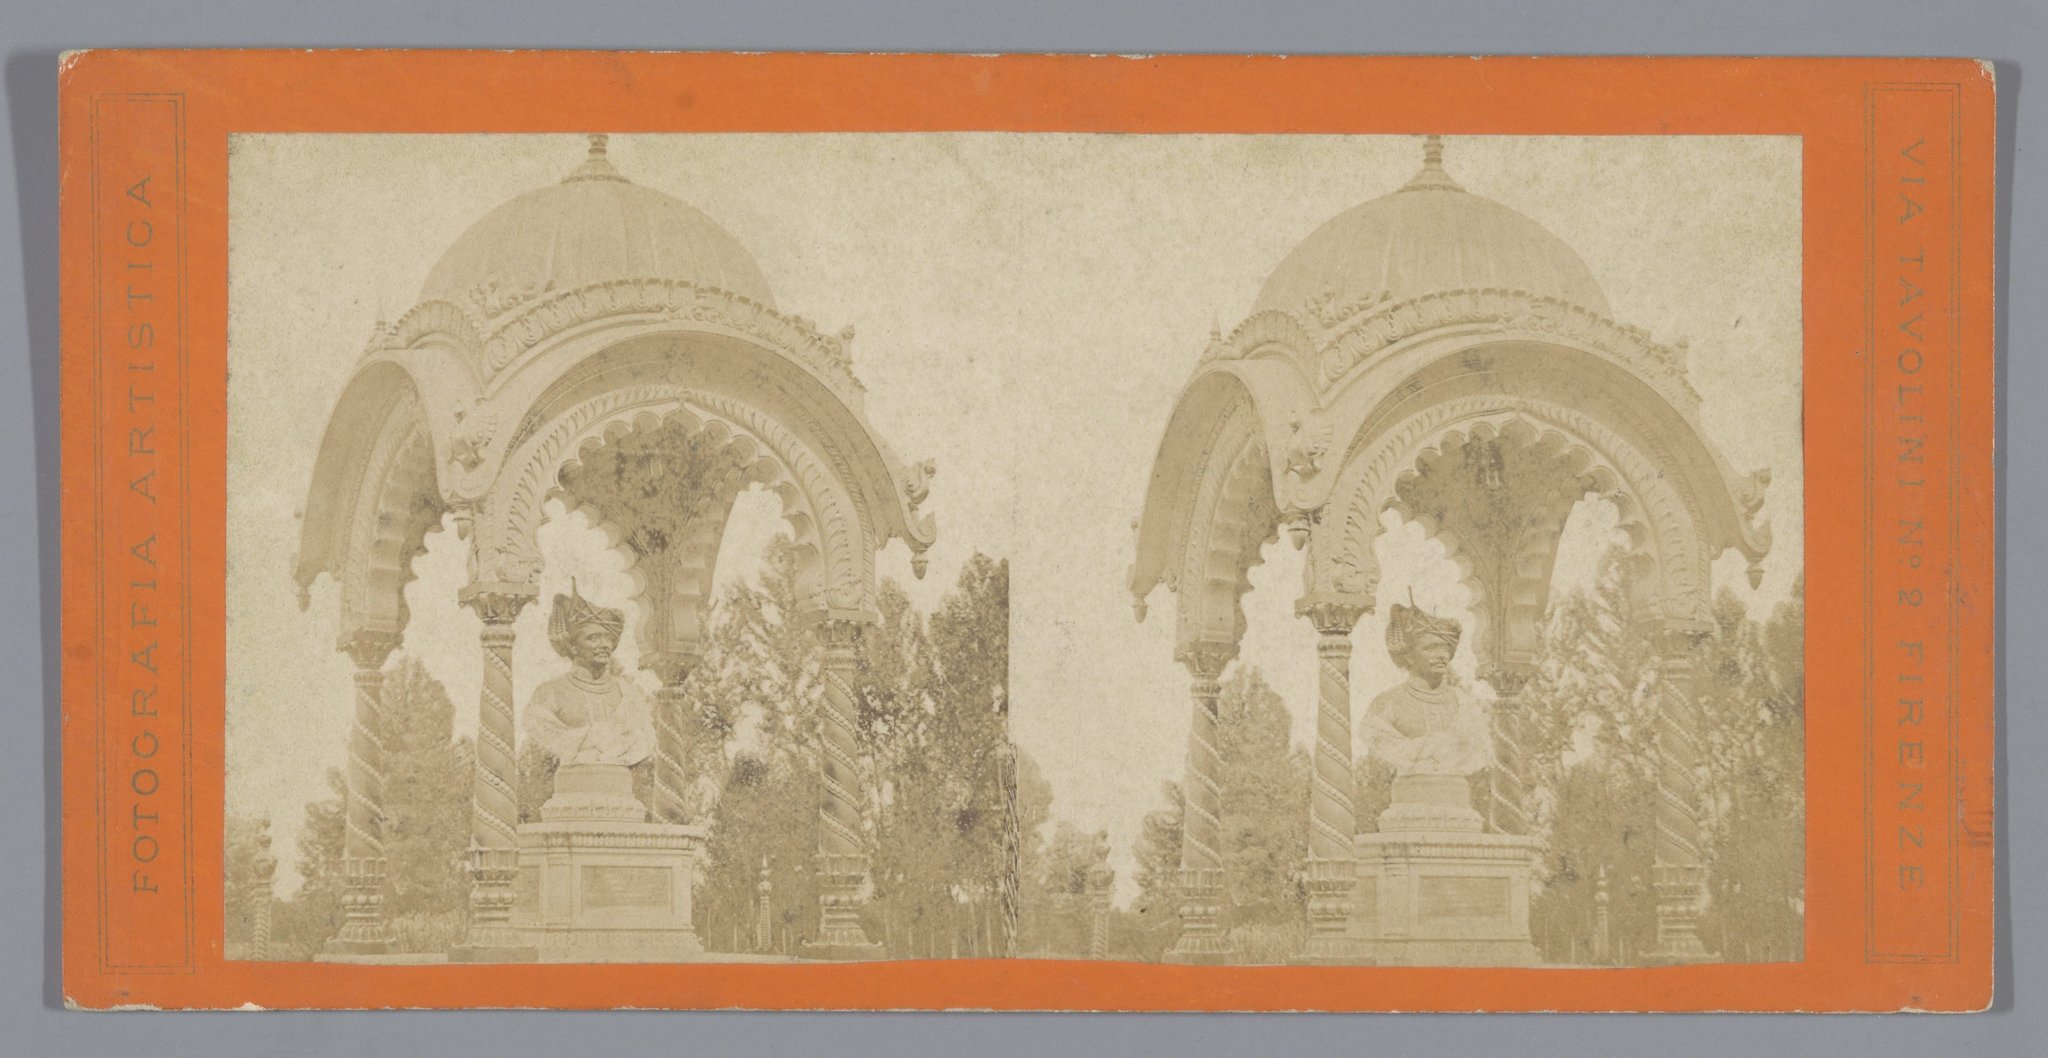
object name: stereograph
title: Monumento all'Indiano te Florence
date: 1850-1880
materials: cardboard, photographic support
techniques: albumen print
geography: parco delle cascine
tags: canopy, baldachin, monument, statue, sculpture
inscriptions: name: ‘FOTOGRAFIA ARTISTICA VIA TAVOLINI No 2 FIRENZE’, inscription: ‘Monumento di Principe Indiano alle Cascine Firenze’